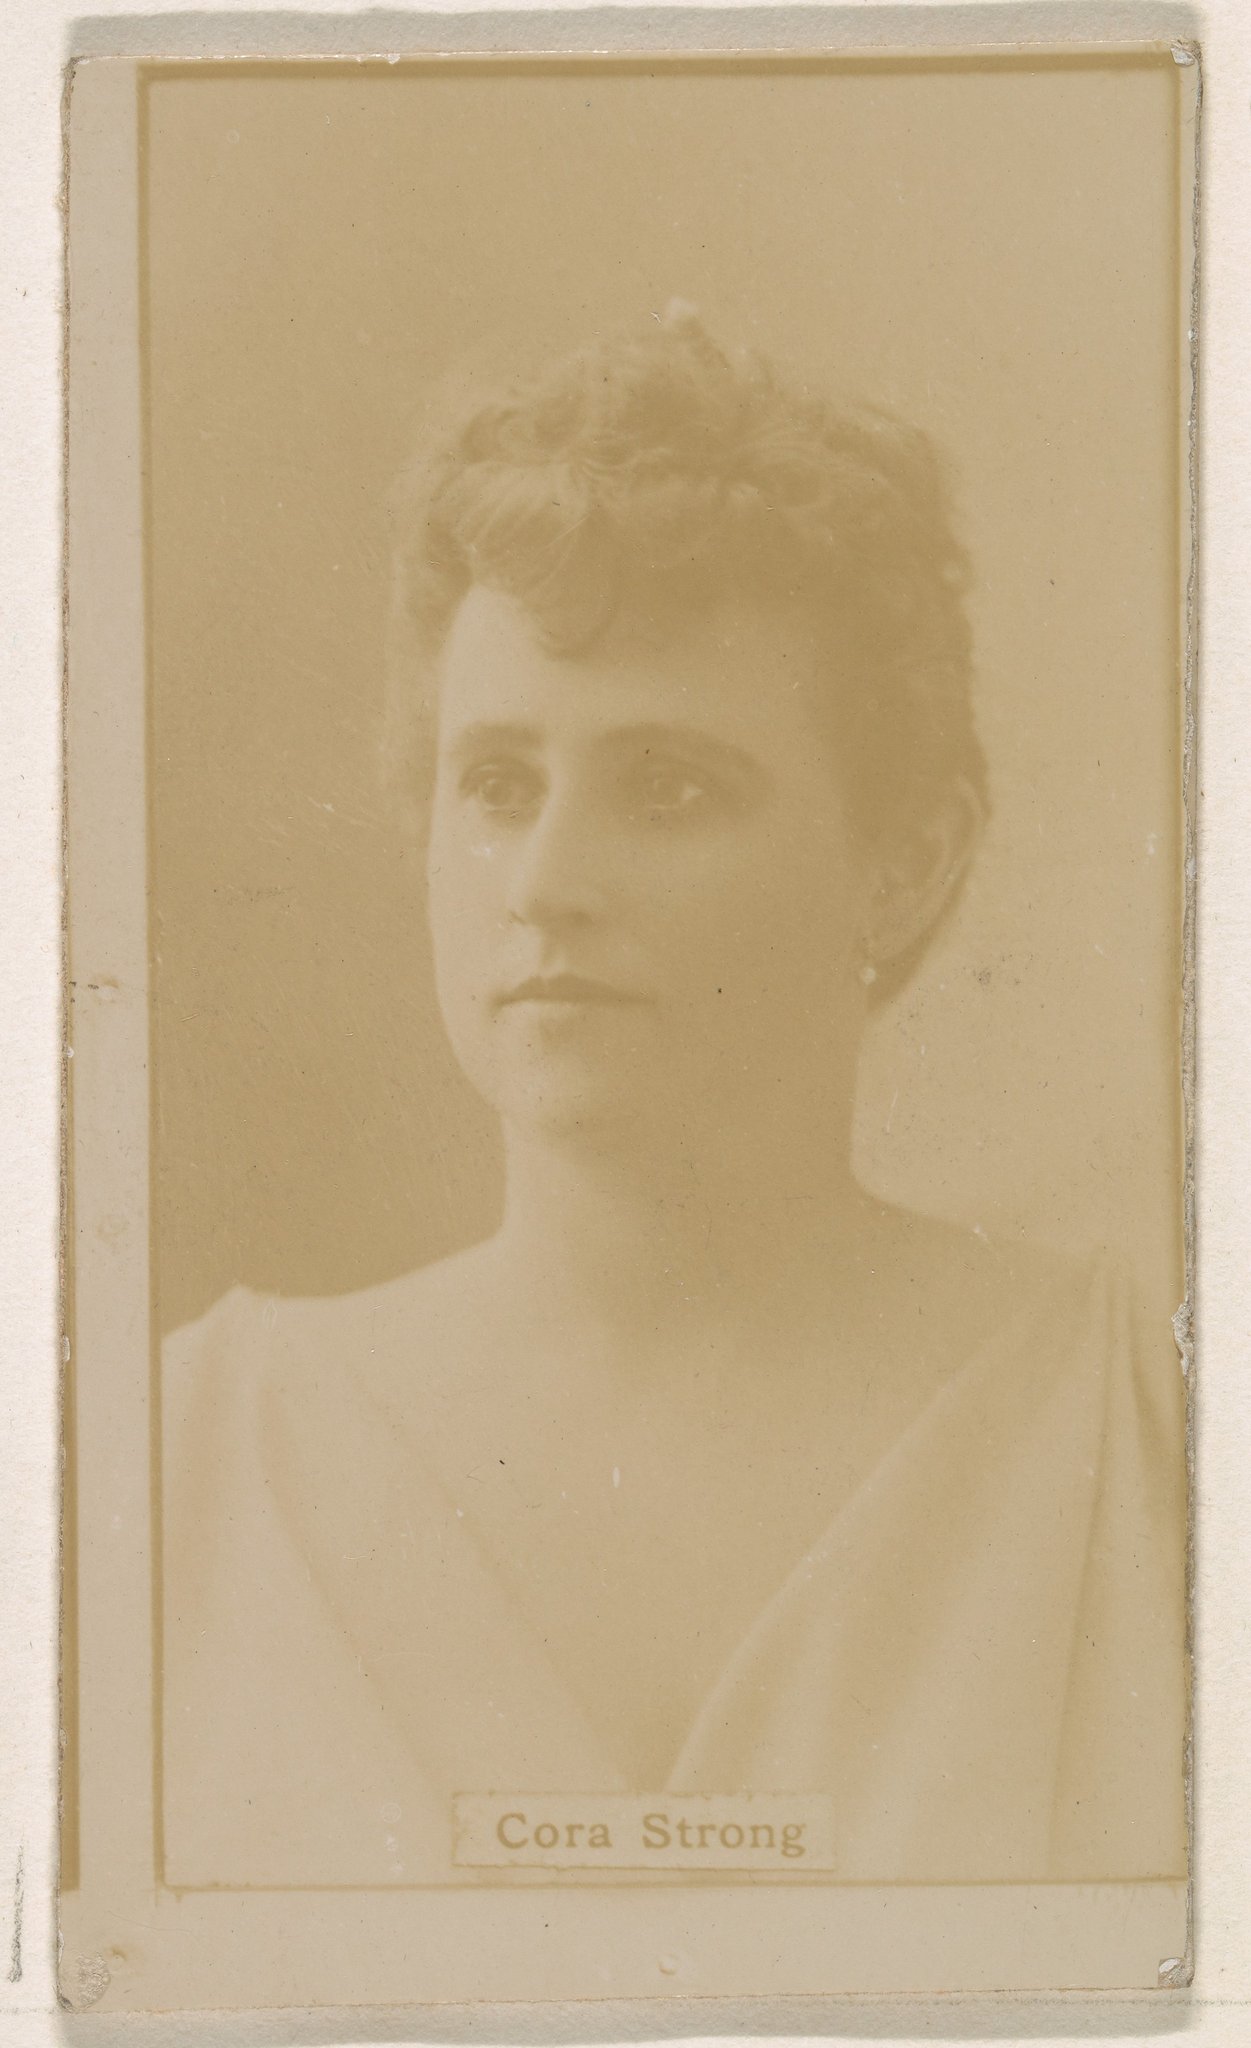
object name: photograph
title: Cora Strong, from the Actresses series (N245) issued by Kinney Brothers to promote Sweet Caporal Cigarettes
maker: kinney brothers tobacco company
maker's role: publisher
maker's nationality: american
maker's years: 1869-2011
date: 1890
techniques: albumen silver print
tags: portraits,women,actresses